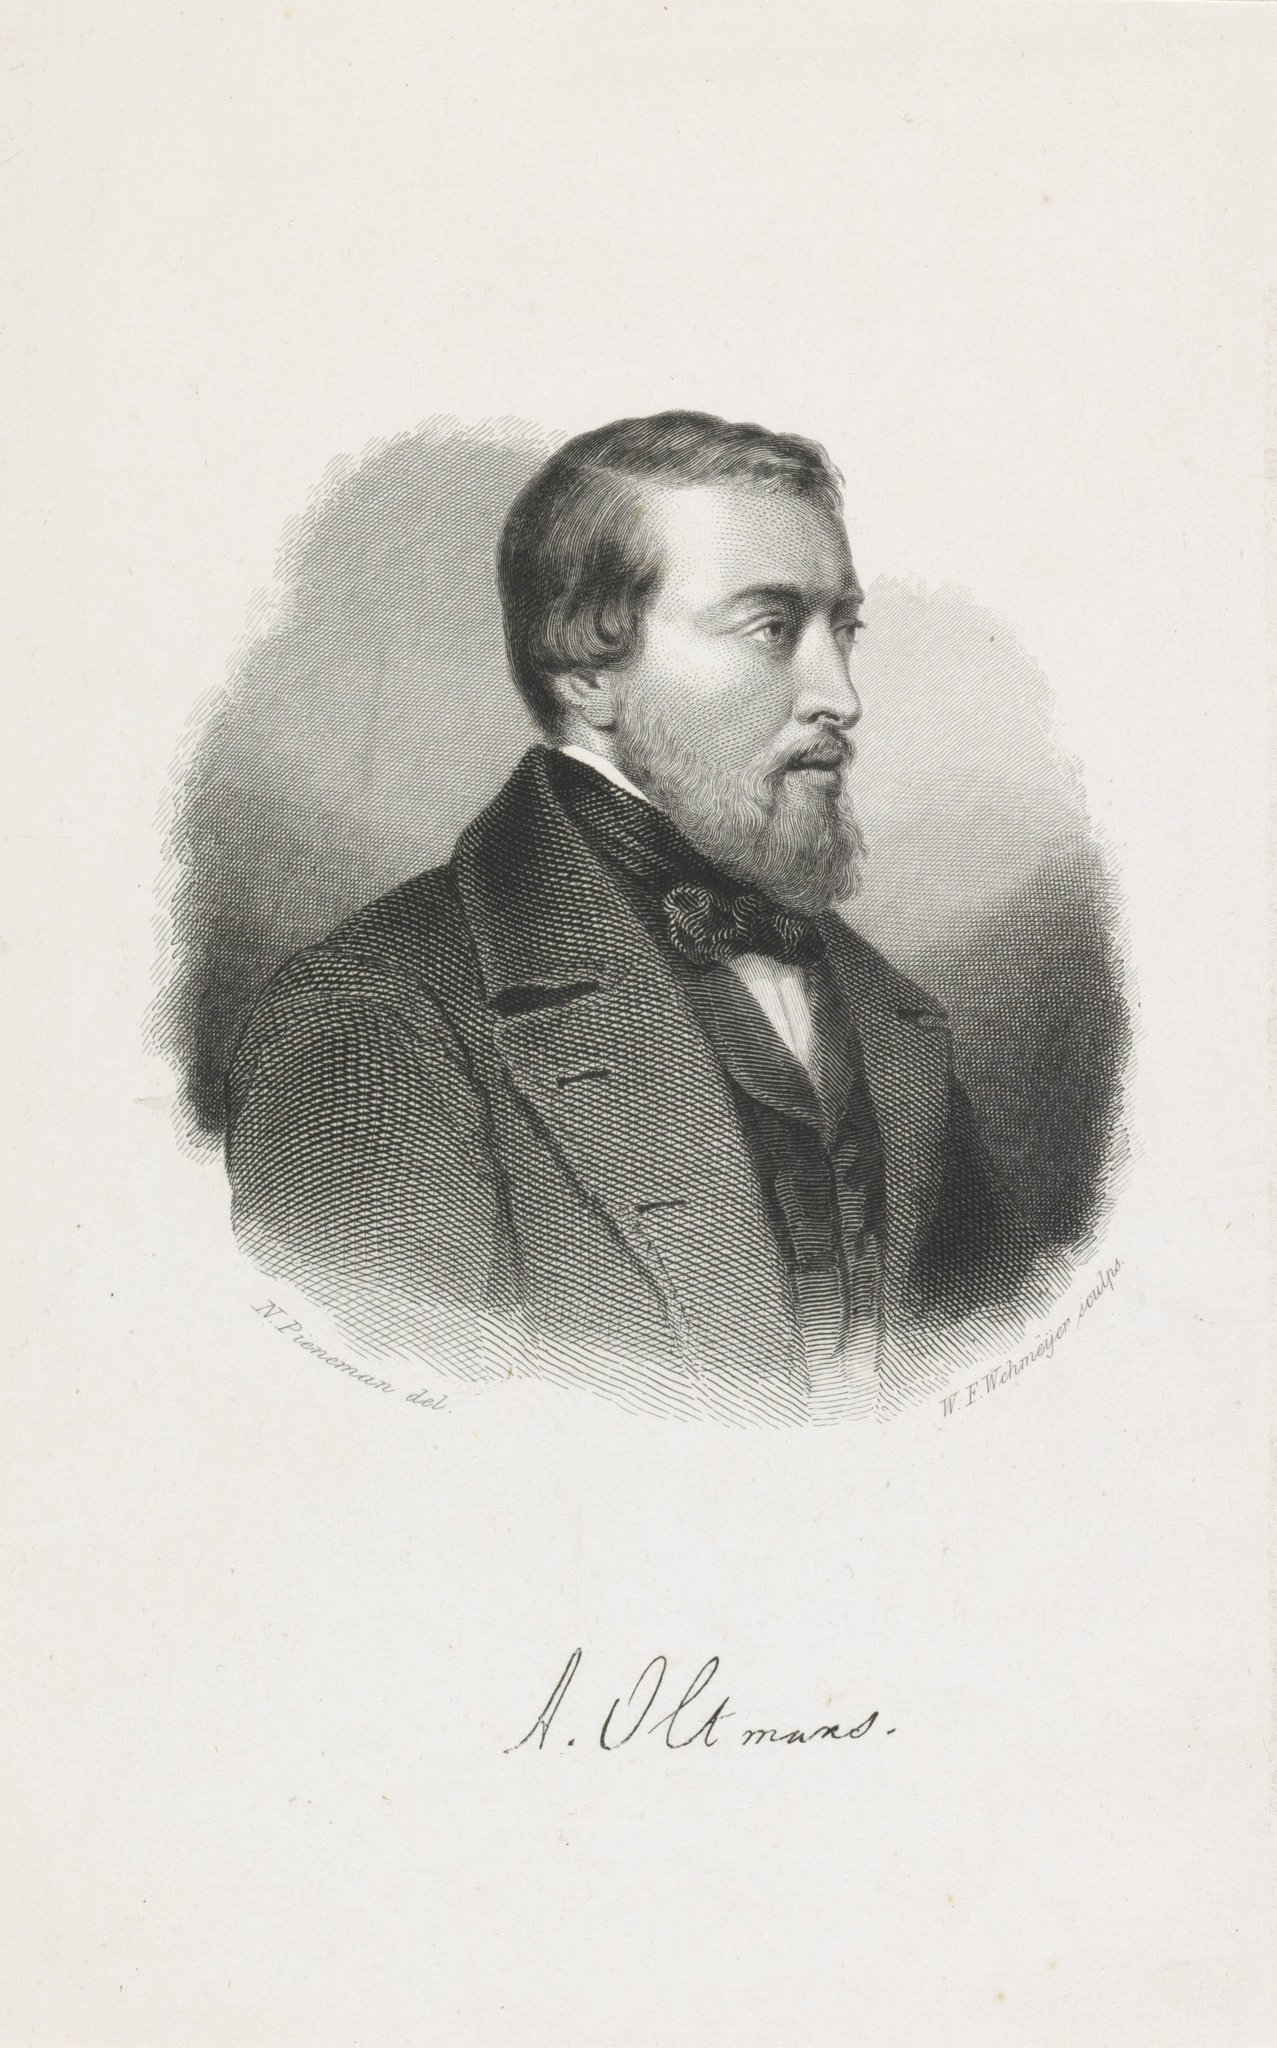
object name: print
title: Portret van Alexander Oltmans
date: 1834-1854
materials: paper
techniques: engraving, etching, roulette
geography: amsterdam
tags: alexander oltmans, adult man, historical persons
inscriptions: collector's mark: Lugt 2228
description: Portret van Alexander Oltmans, kunstenaar. Onder de voorstelling bevindt zich de signatuur van de geportretteerde.